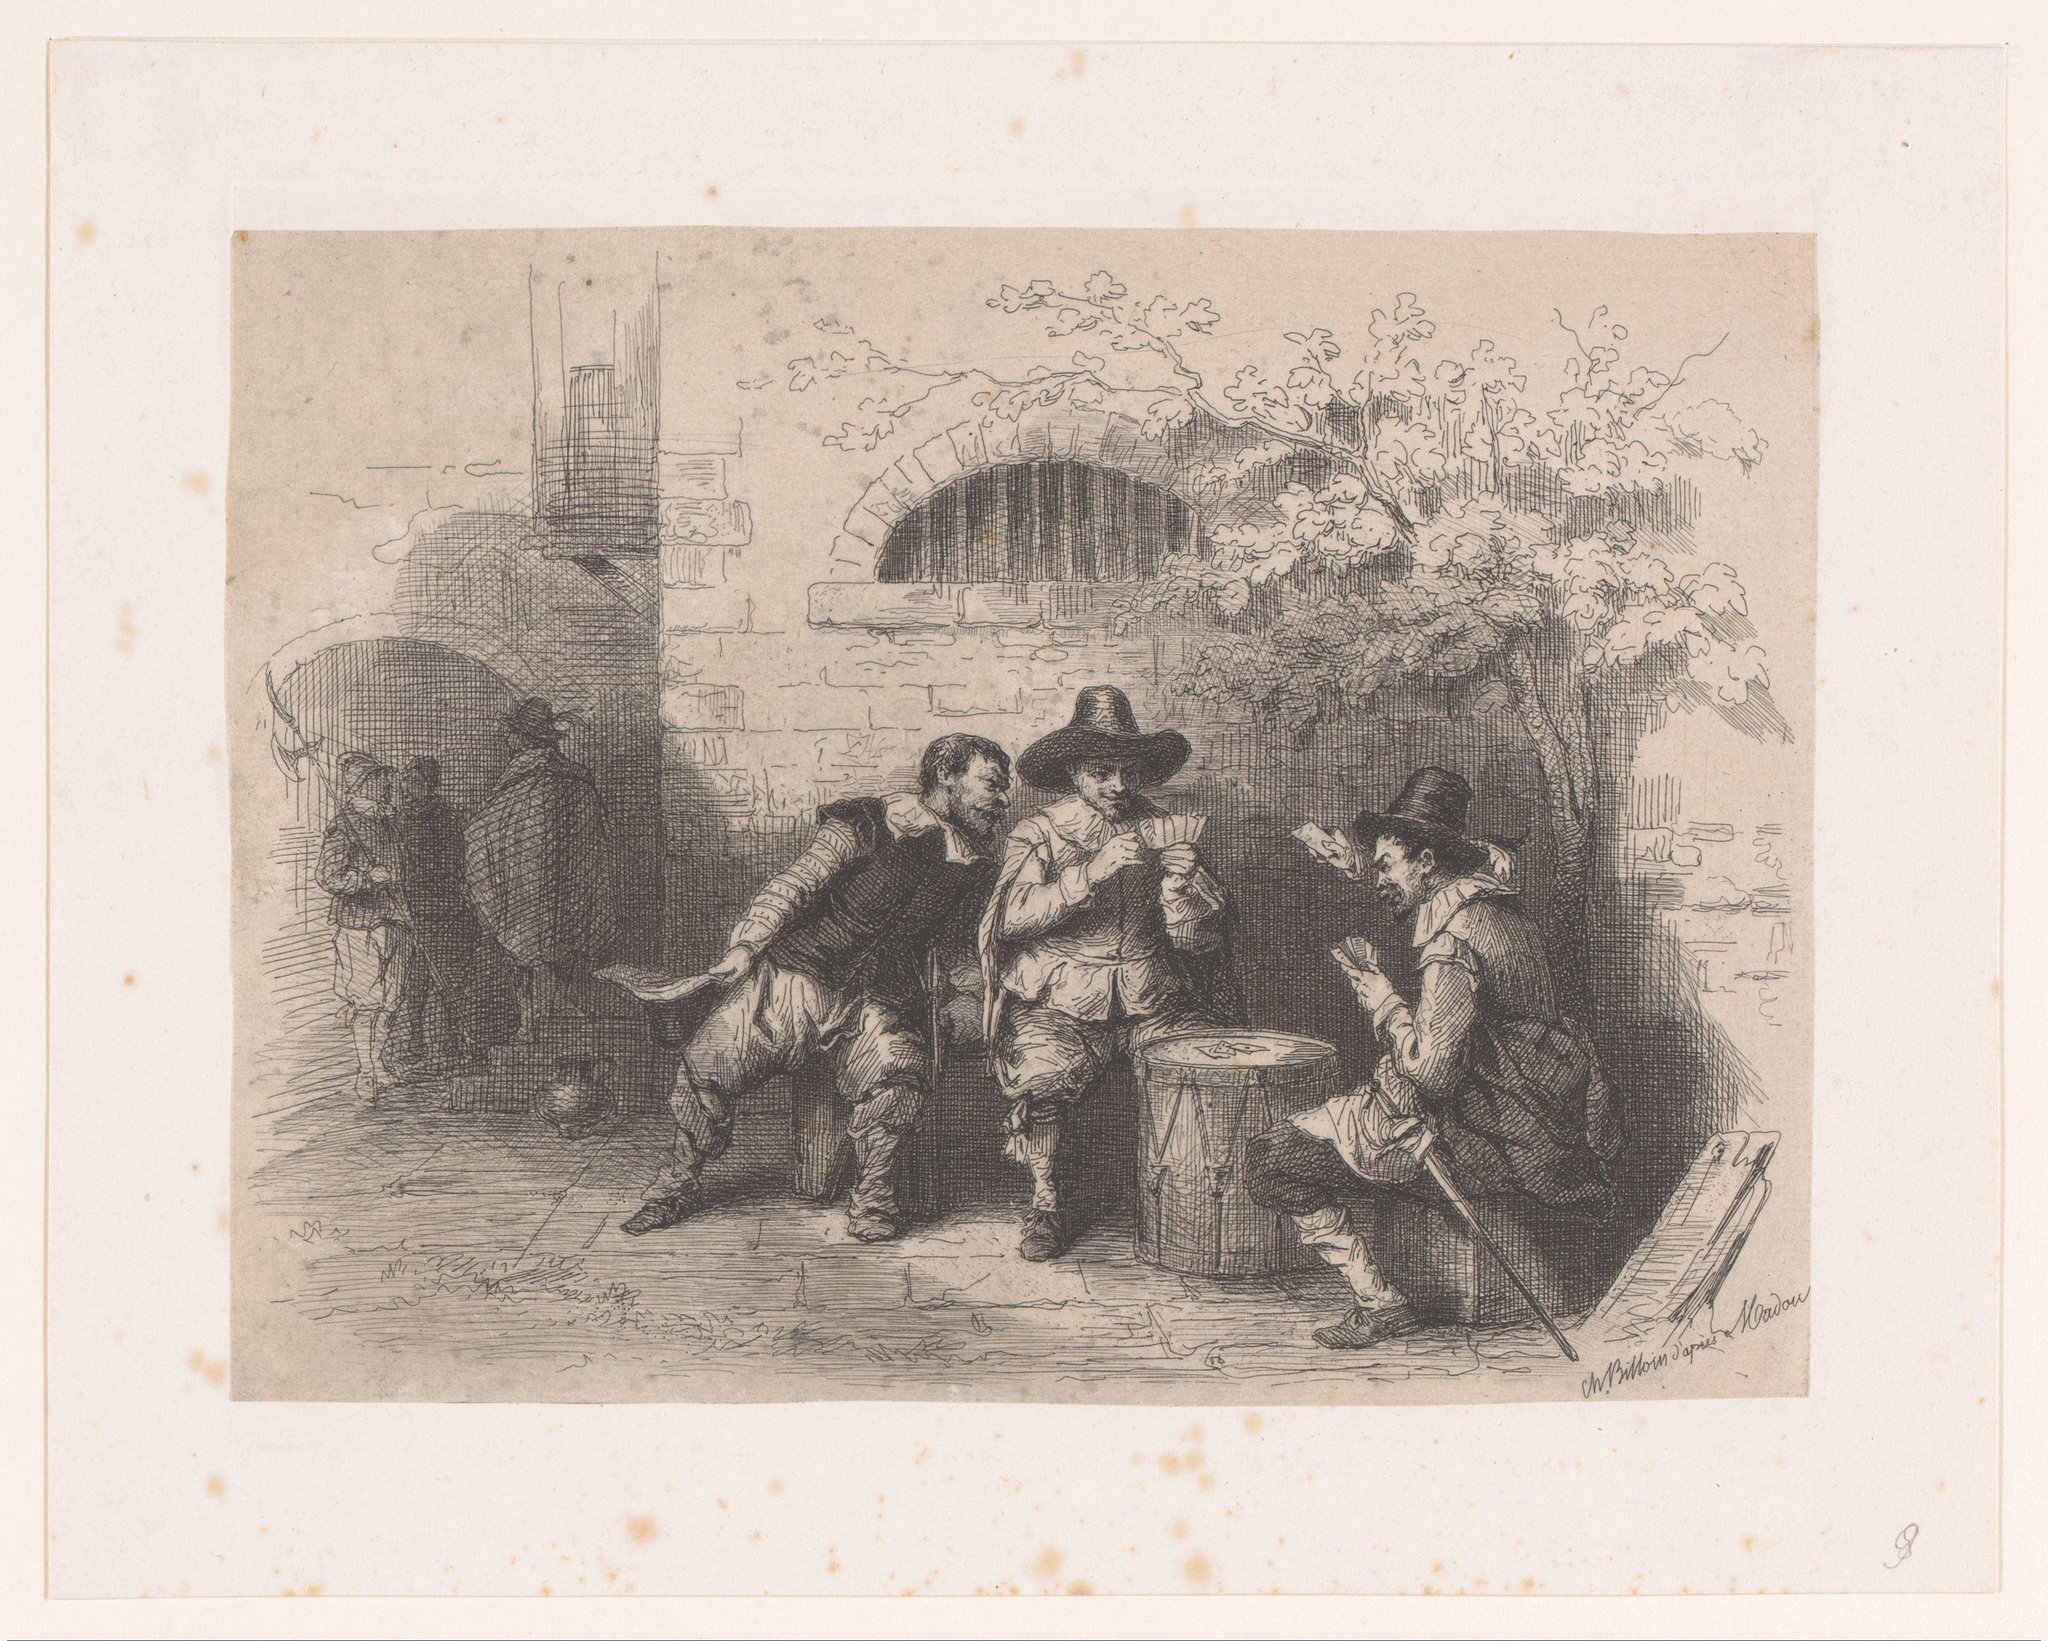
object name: print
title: Kaartspelende militairen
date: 1850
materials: paper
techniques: etching, intaglio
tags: card games, guard duty, keeping sentry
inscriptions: collector's mark: Lugt 1485, collector's mark: Lugt 2228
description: Deze prent is gebruik voor de titelpagina van: Les peintres Belges au XIXe. siècle. Première série. Sujets de genre. Brussel: Dero-Becker fils, 1850. Deze suite etsen bevat zes etsen van Billoin naar Madou.